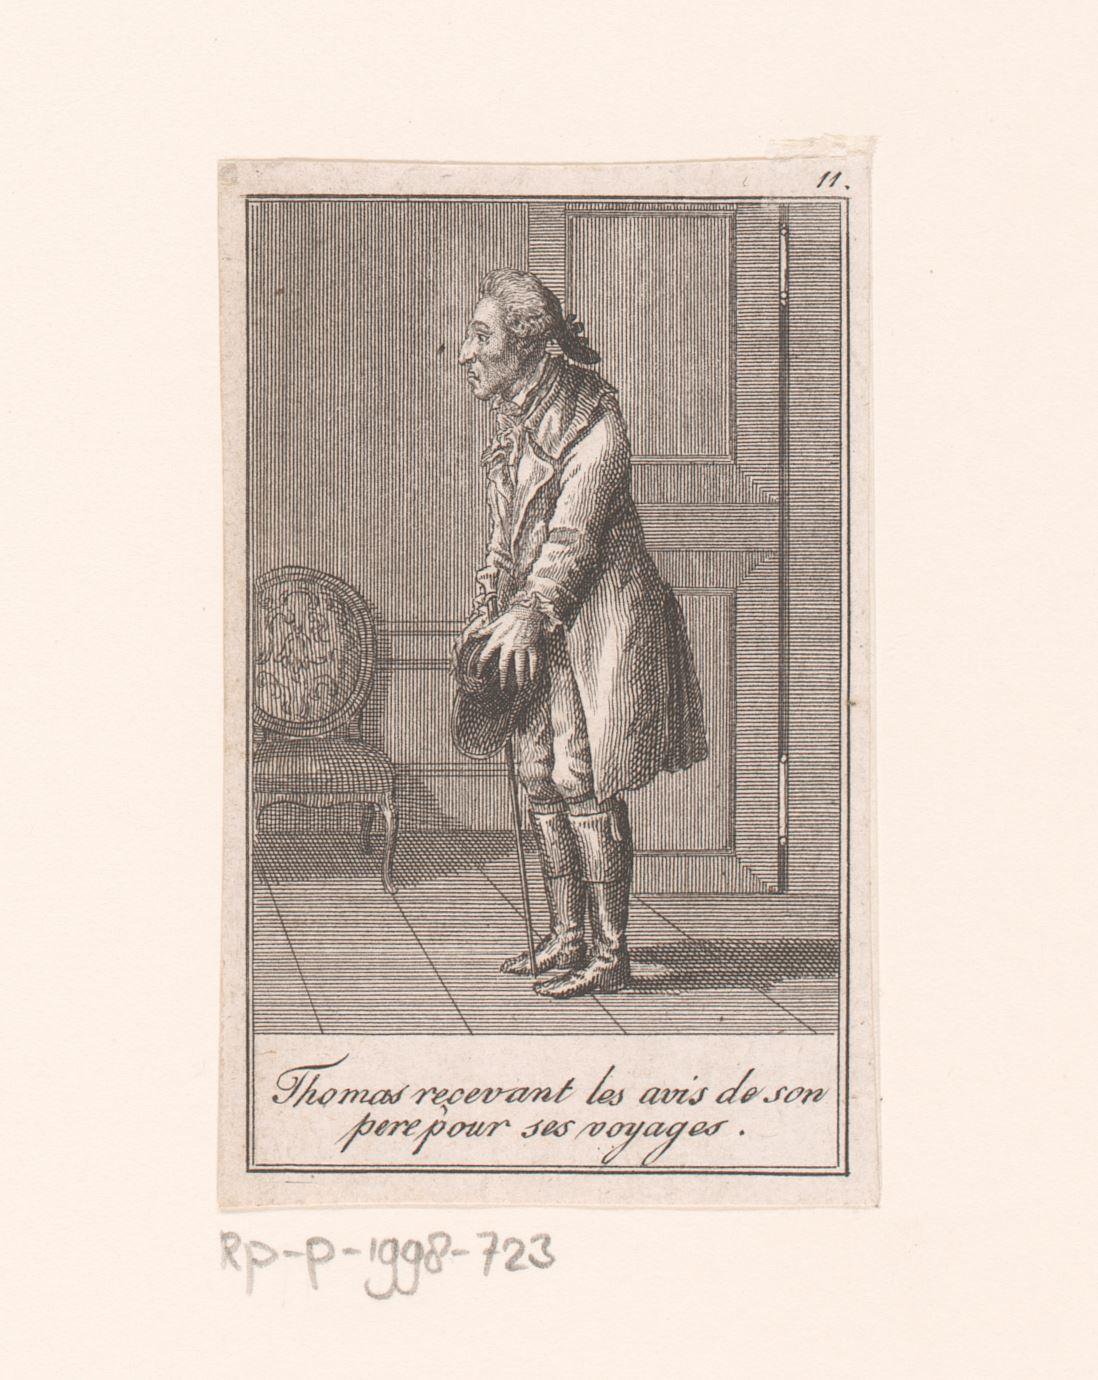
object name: print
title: Thomas ontvangt reisadvies van zijn vader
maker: karl heinrich grünler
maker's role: print maker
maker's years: 1761-1823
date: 1771-1823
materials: paper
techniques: etching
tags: adult man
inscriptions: collector's mark: Lugt 2228